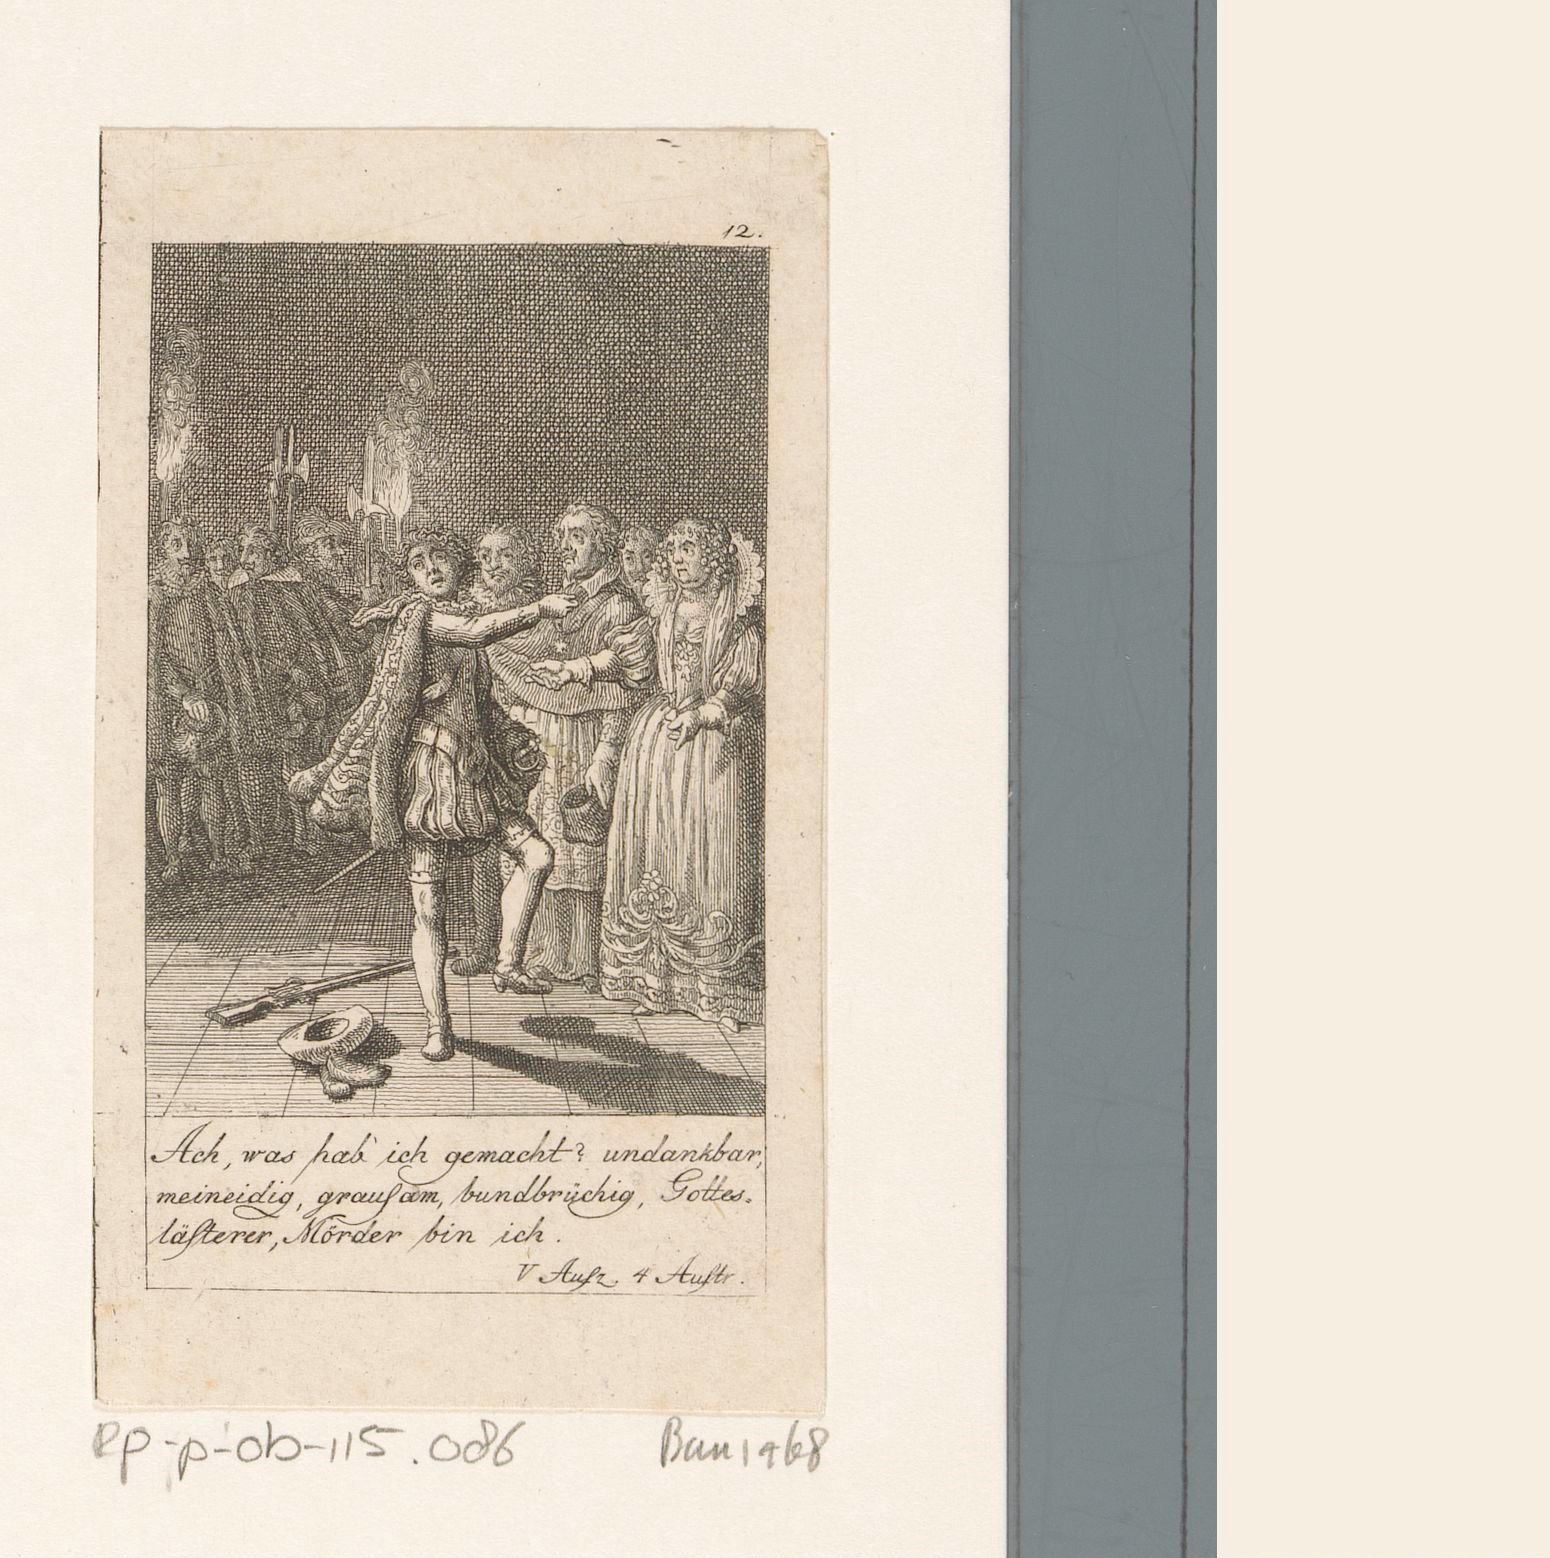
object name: print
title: Karel IX bekent zijn schuld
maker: daniel nikolaus chodowiecki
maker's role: draughtsman, print maker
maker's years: 1726-1801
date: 1790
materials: paper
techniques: etching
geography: berlin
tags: karel ix (koning van frankrijk), history, despair; 'disperatione' (ripa), ruler, sovereign, regret, paris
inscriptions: collector's mark: Lugt 2228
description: Vervaardigd voor 'Charles IX' van Marie-Joseph Chénier. Prent gebruikt voor: Goettinger Taschen Calender für 1791. bey Joh. Chr. Dietrich. Göttingen: Johann Christoph Dietrich, [1790].